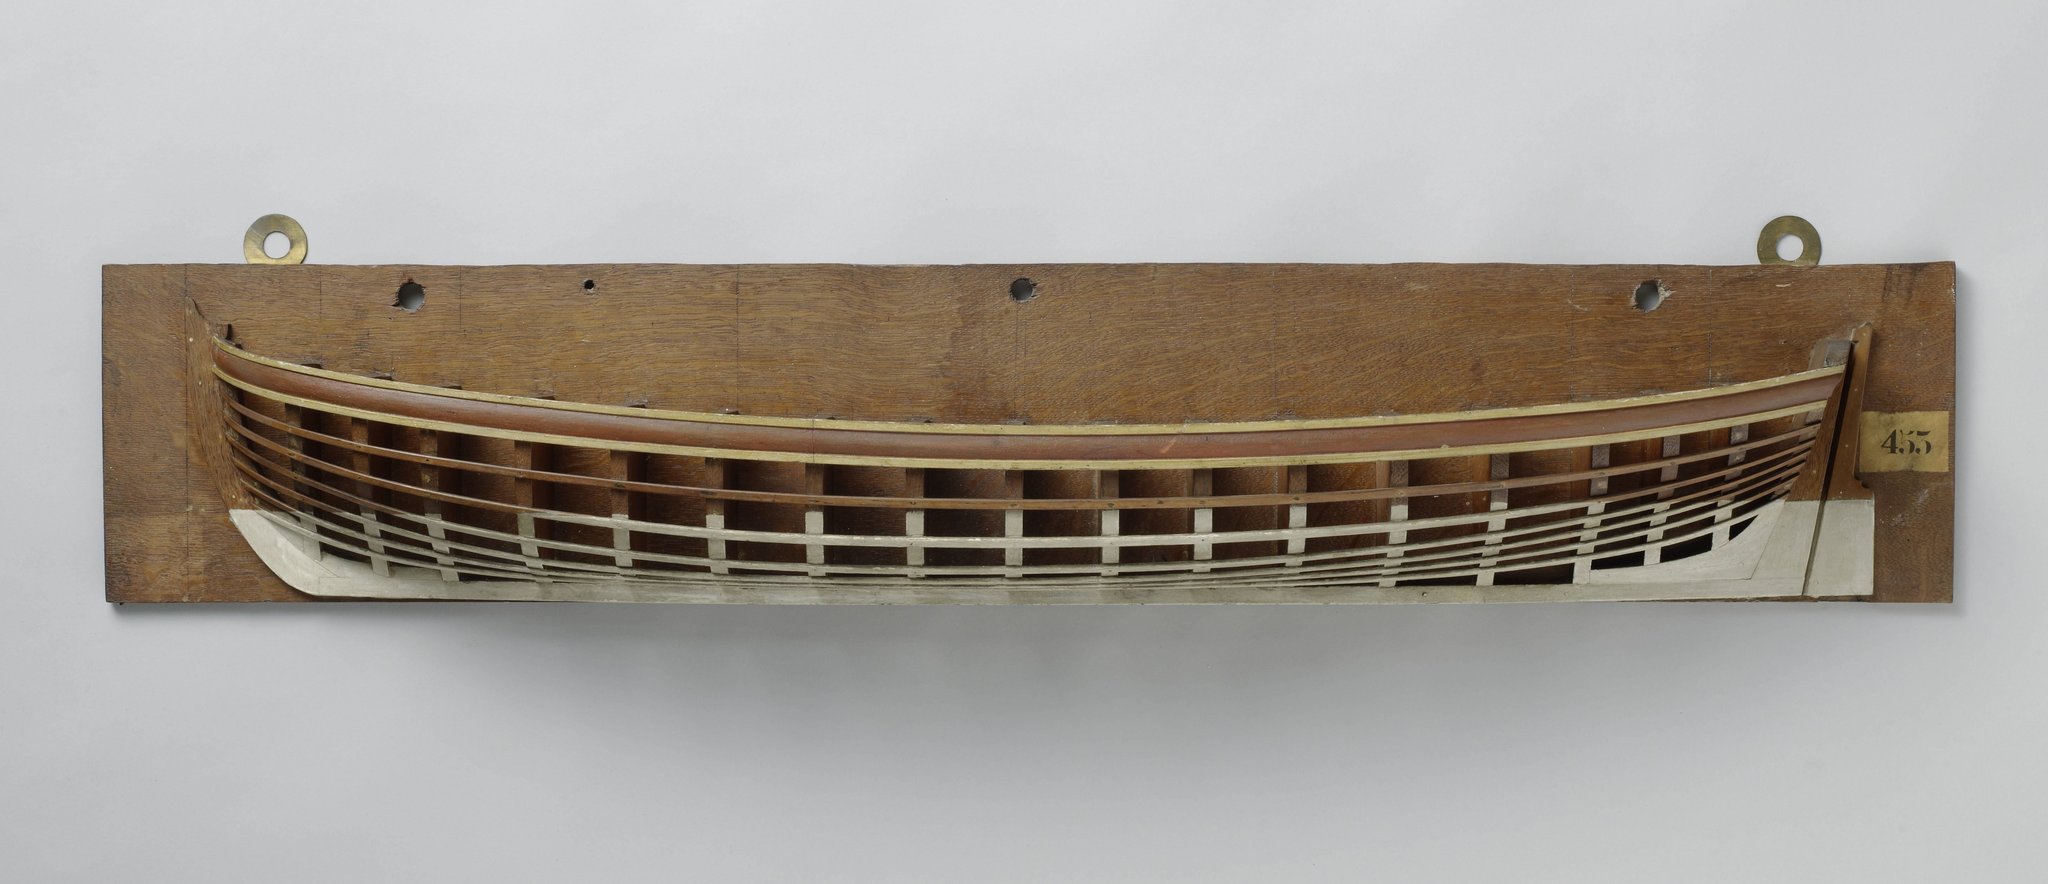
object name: ship model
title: Half Model of a Launch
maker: Anonymous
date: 1780-1820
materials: wood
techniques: polychromy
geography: netherlands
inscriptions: label, centre right: ‘453’ former inventory label